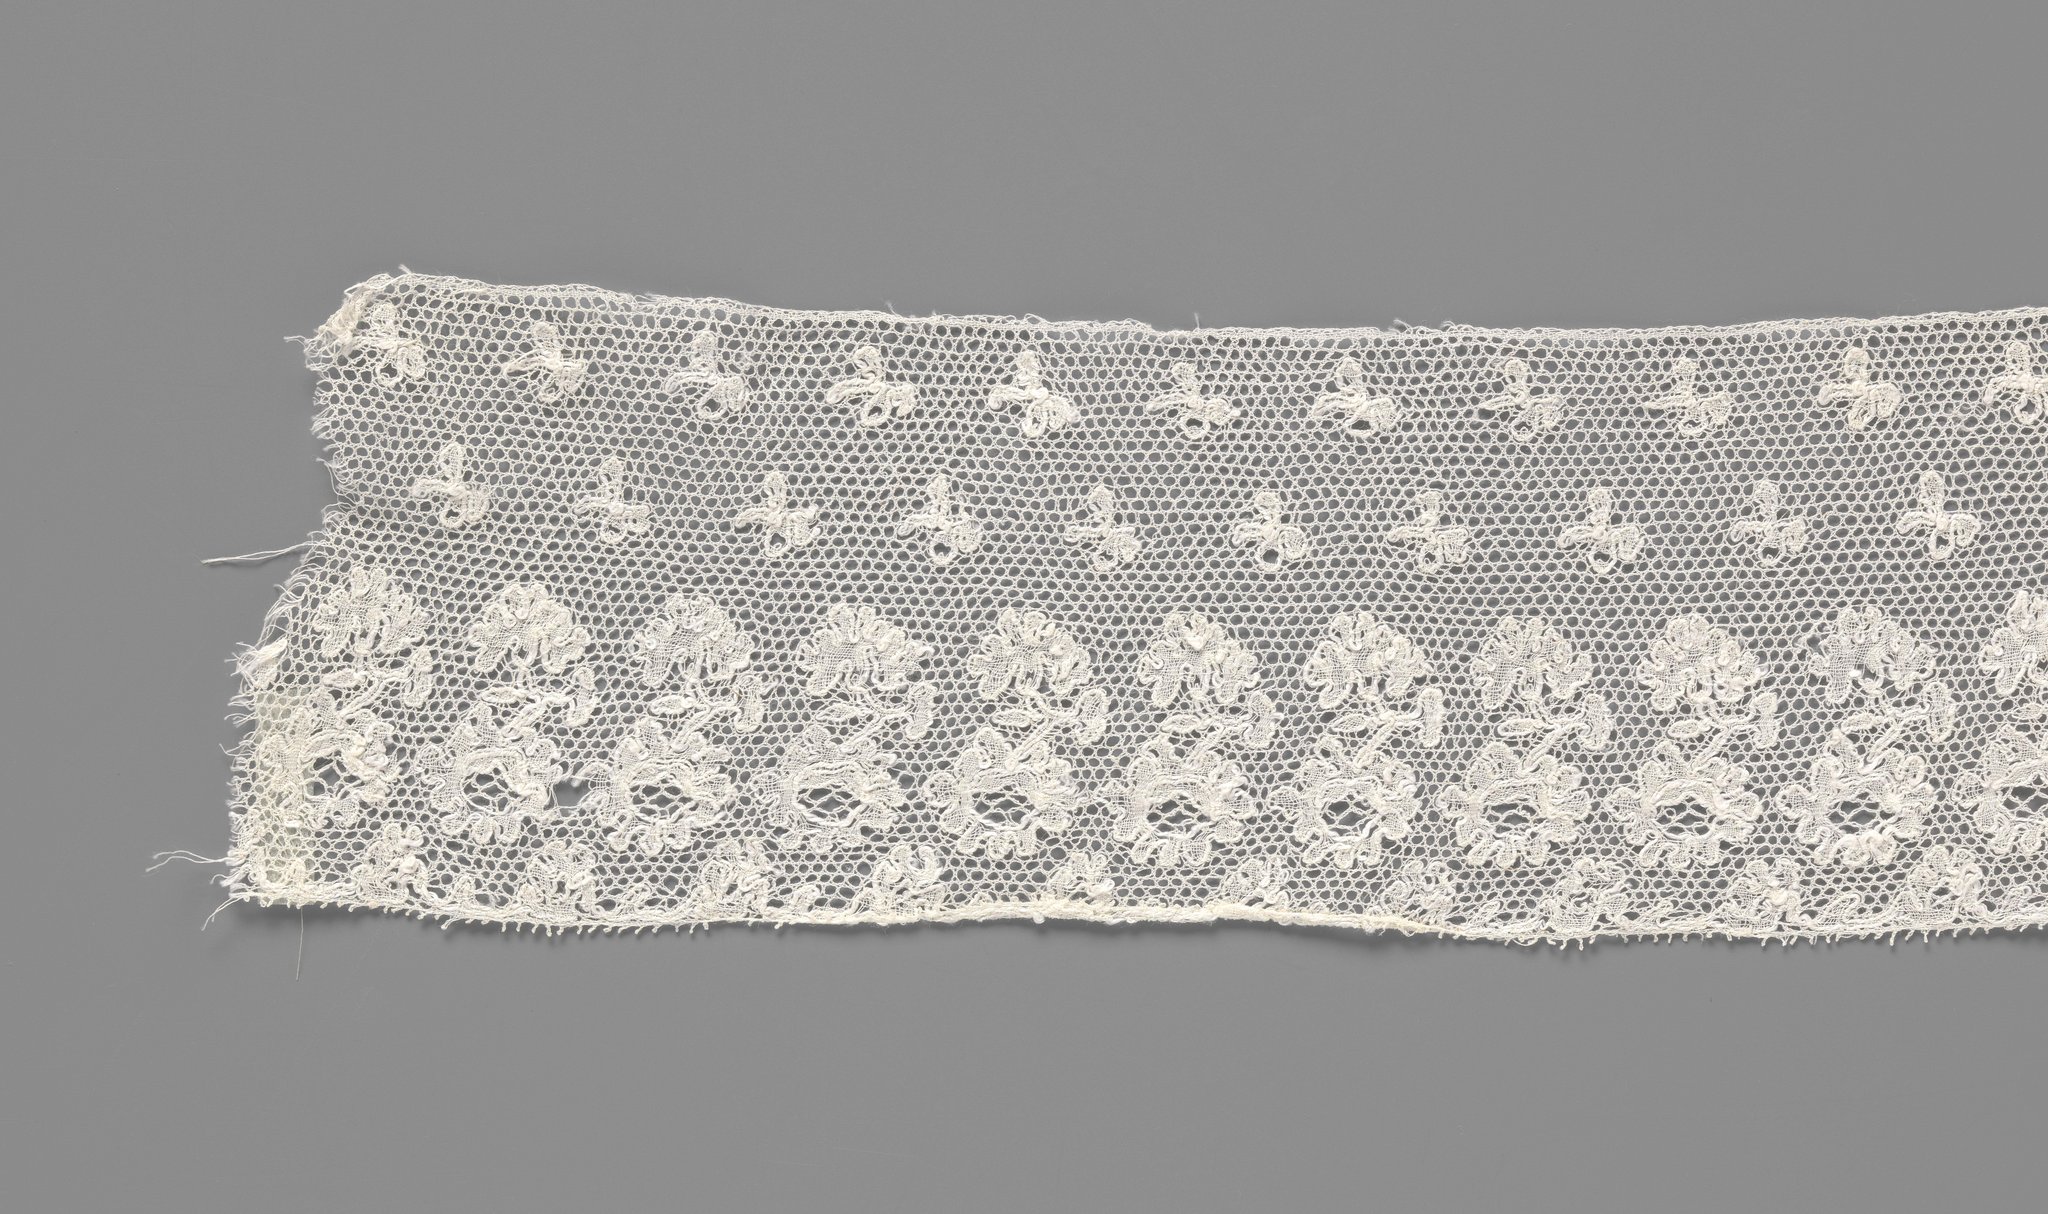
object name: strip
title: Strook kloskant met twee rijen strikjes en een rij hangende bloemen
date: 1800-1899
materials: linen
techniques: lace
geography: flanders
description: Strook naturelkleurige kloskant, Parijse kant. De bovenste helft van het patroon bestaat uit twee rijen strikjes. De onderste helft van het patroon bestaat uit een rij gespleten takjes, waaraan steeds één blad omhoog buigt en één bloem naar beneden. Langs de onderzijde loopt een rand die bestaat uit een aaneenschakeling van liggende steeltjes met daaraan steeds één bloempje en één blaadje. De motieven zijn met elkaar verbonden door een maasgrond, een Parijse grond. De motieven zijn gemaakt in linnenslag met dikkere en glimmende contourdraden. Bij de hangende bloemen is in elk opengewerkt hart eenzelfde grovere siergrond toegepast. De boven- en onderzijde van de strook zijn recht afgewerkt, waarbij de onderzijde is voorzien van picots.